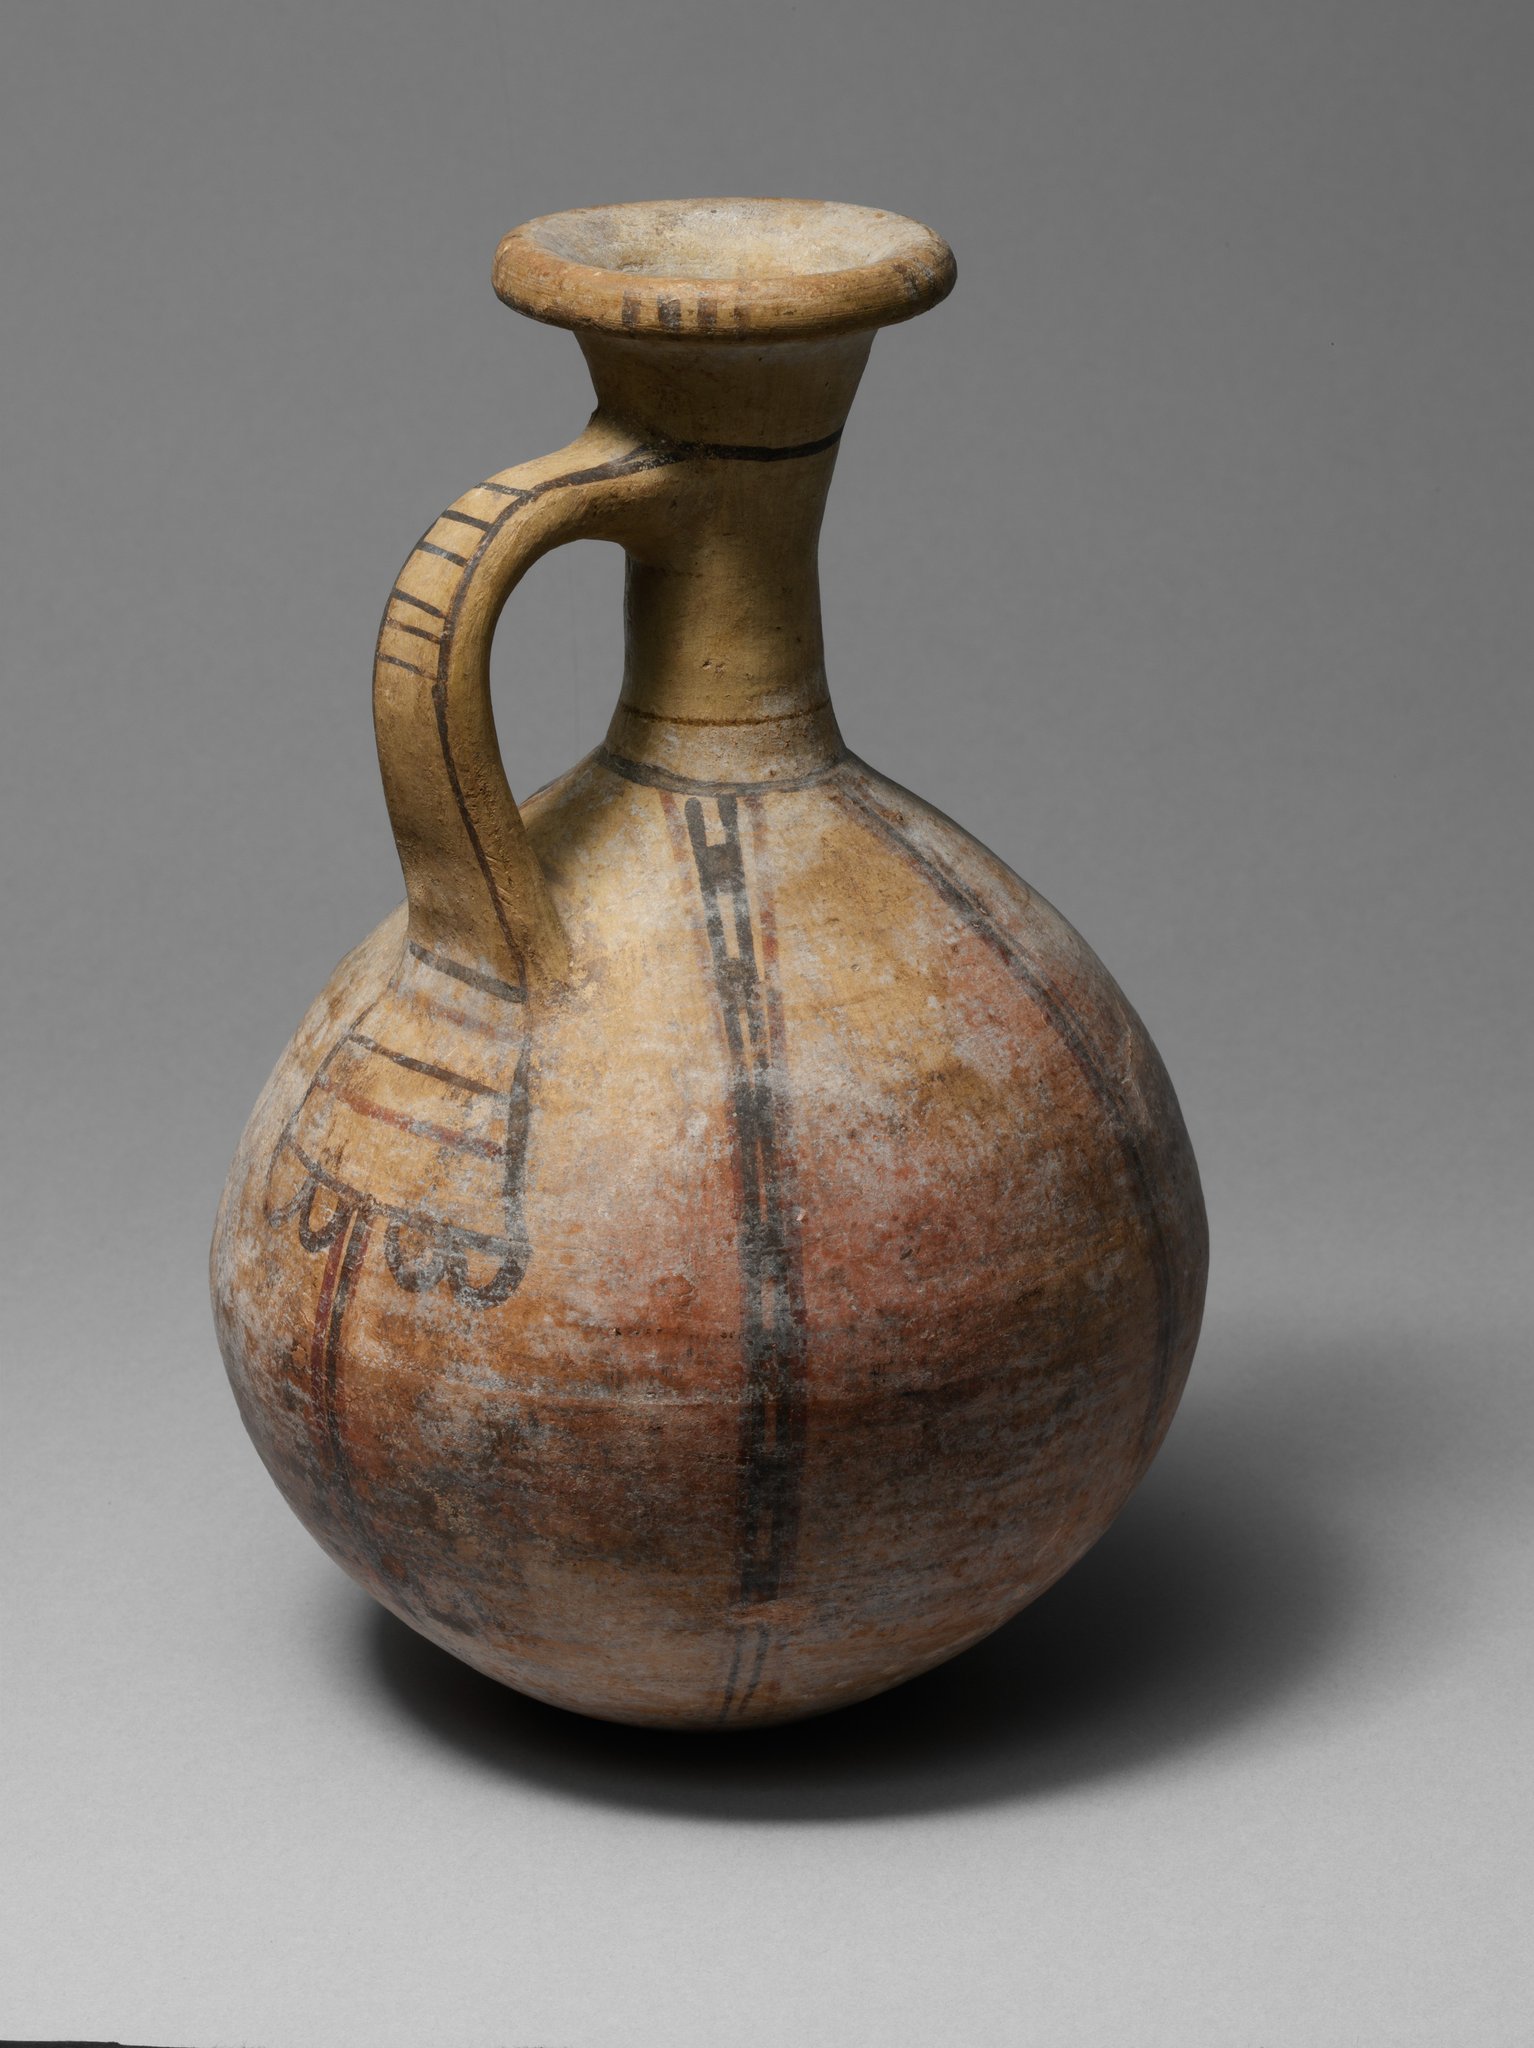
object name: jug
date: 1550-1458 BCE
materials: pottery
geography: egypt